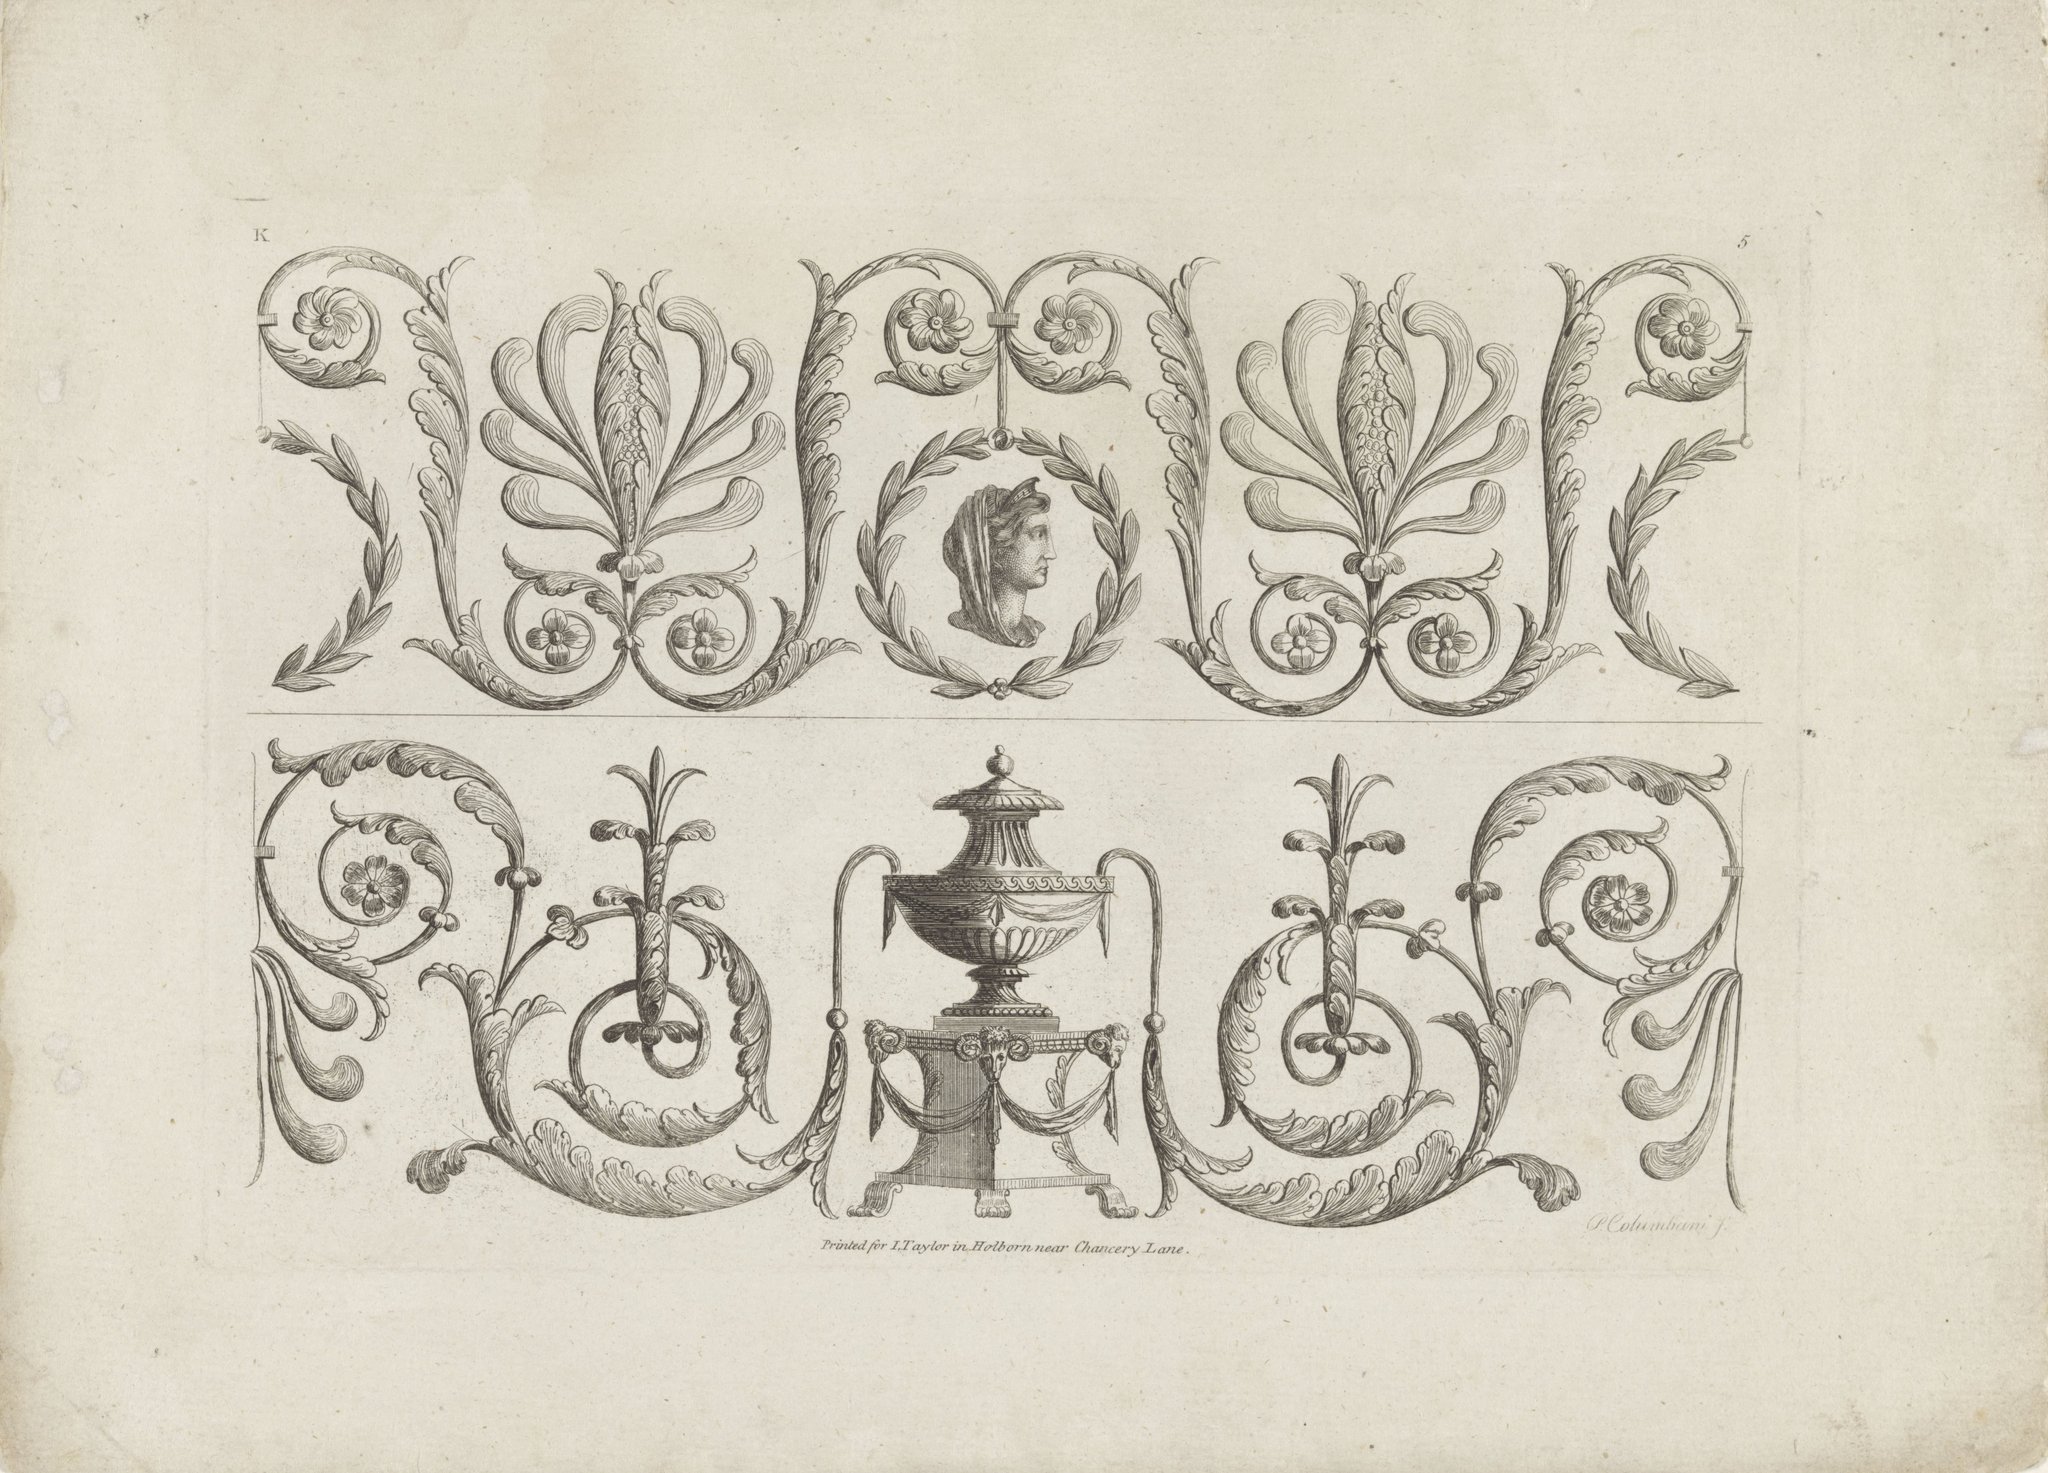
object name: ornament print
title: Twee ornamentranden met portret en vaas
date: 1776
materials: paper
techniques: etching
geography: london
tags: foliage ~ ornament, vase ~ ornament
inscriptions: collector's mark: Lugt 2760, collector's mark: Lugt 2228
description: Titelprent bij een reeks van 12 ornamentprenten.